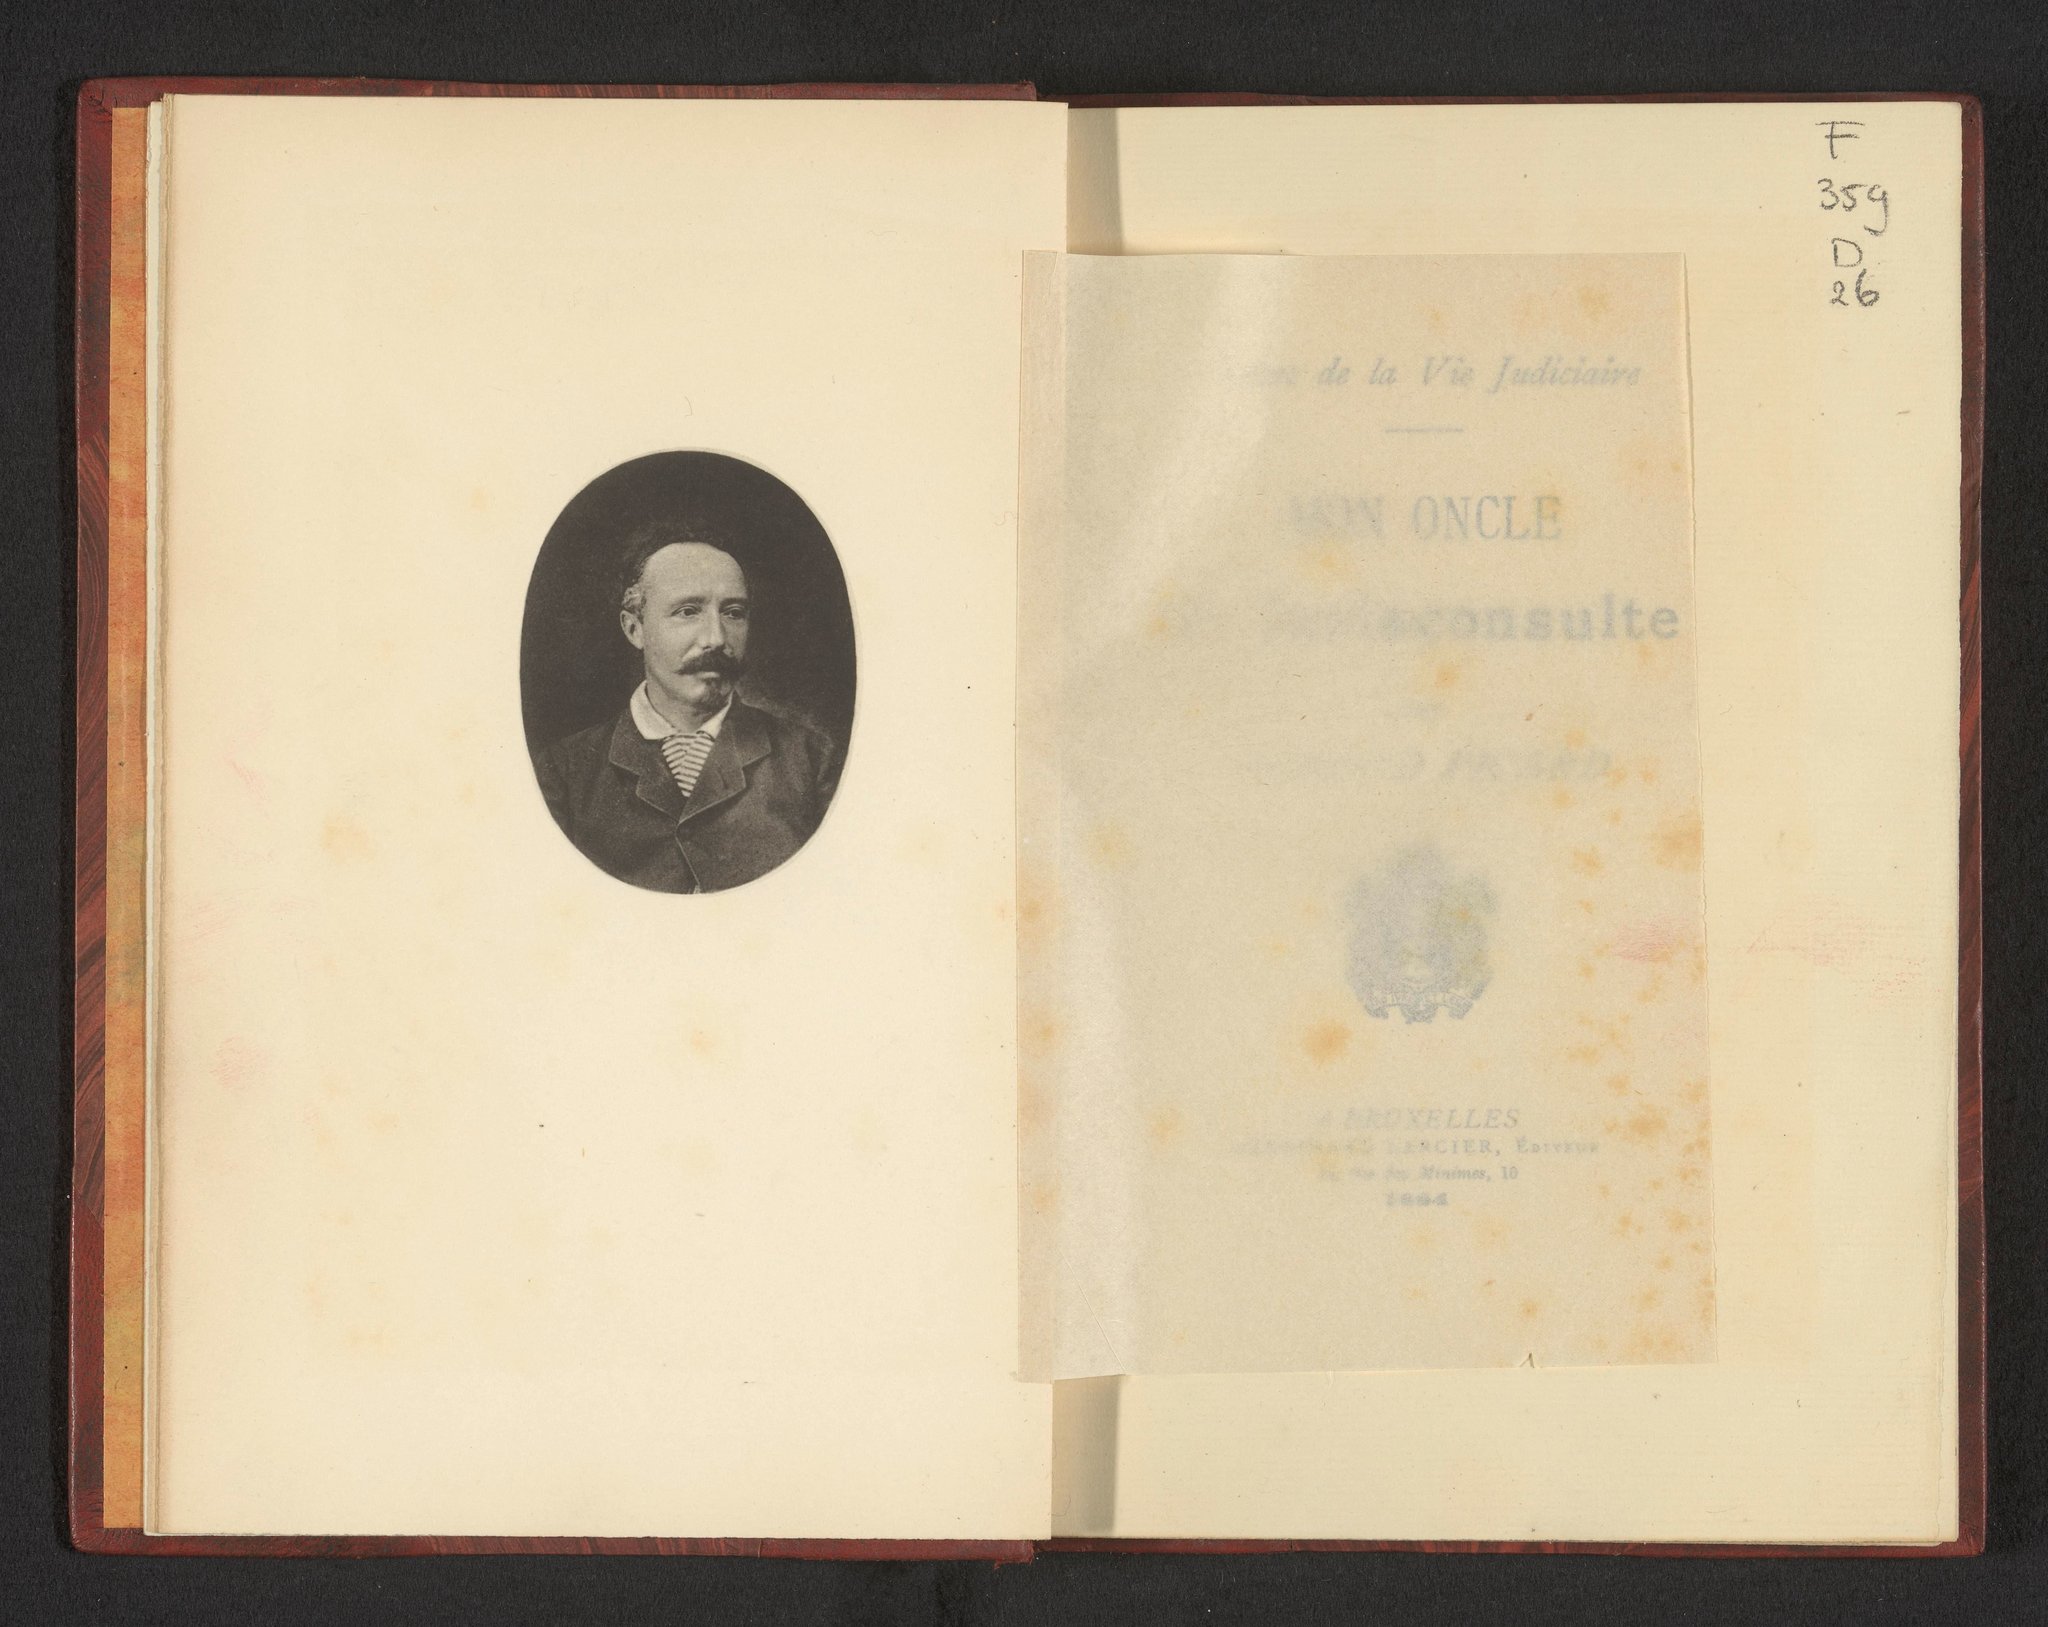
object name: page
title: Portret van Edmond Picard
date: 1879-1884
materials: paper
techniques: photoaquatint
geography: brussels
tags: edmond picard, historical persons